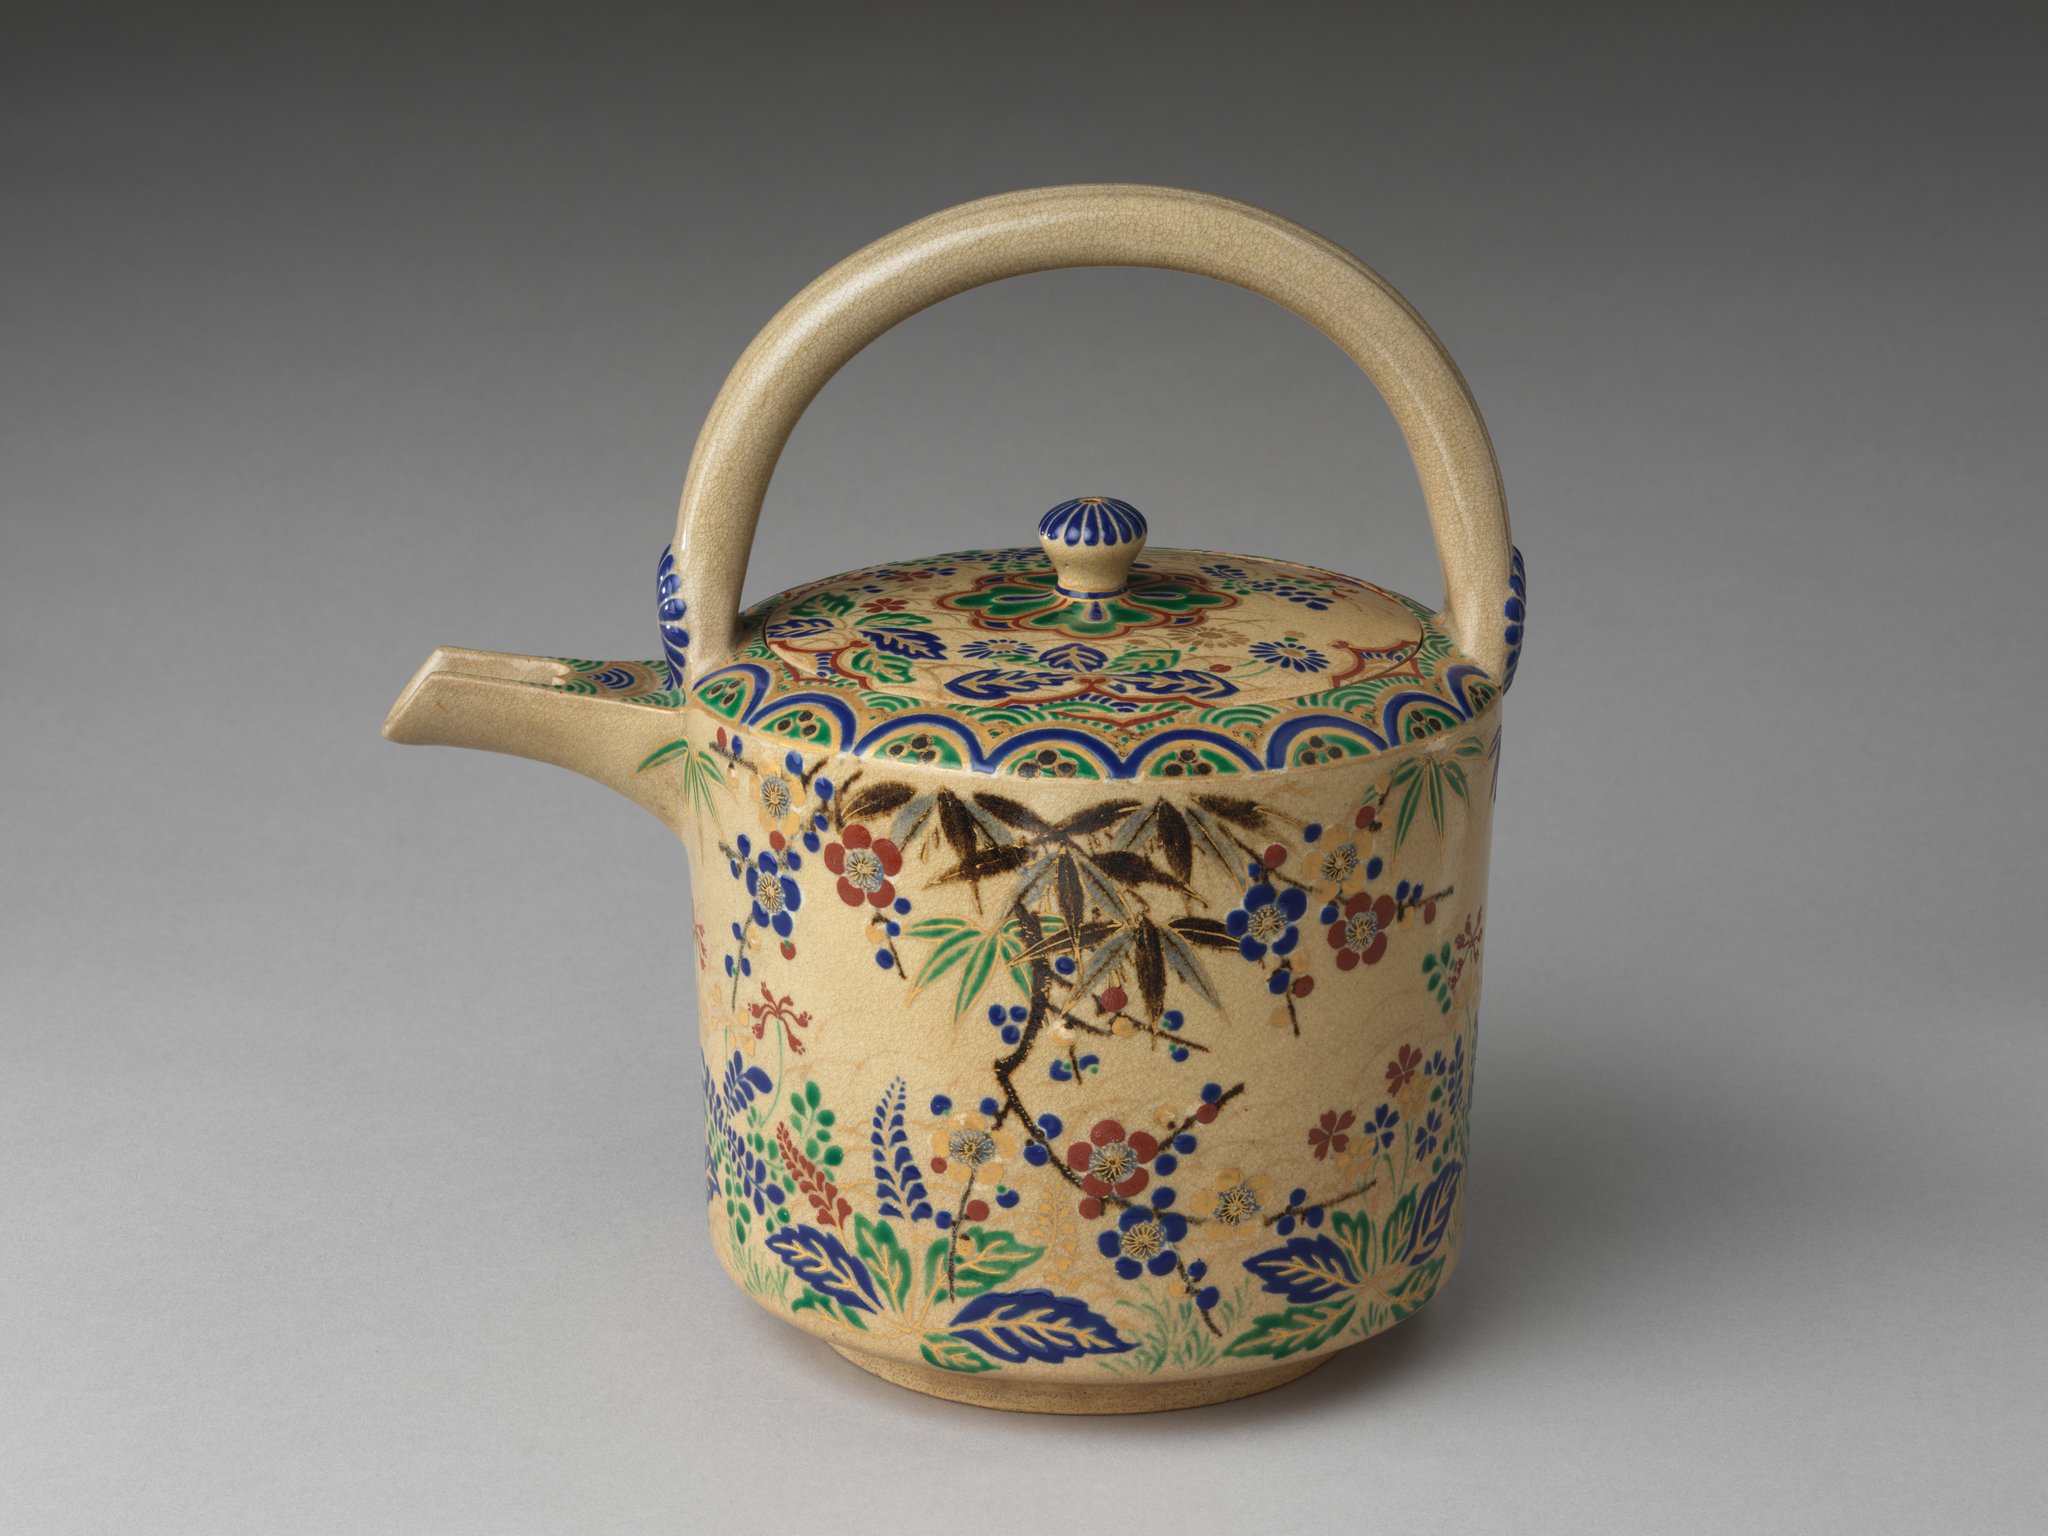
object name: pitcher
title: Water pitcher (Mizutsugi)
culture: japanese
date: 1615-1868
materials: earthenware, glaze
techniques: polychrome